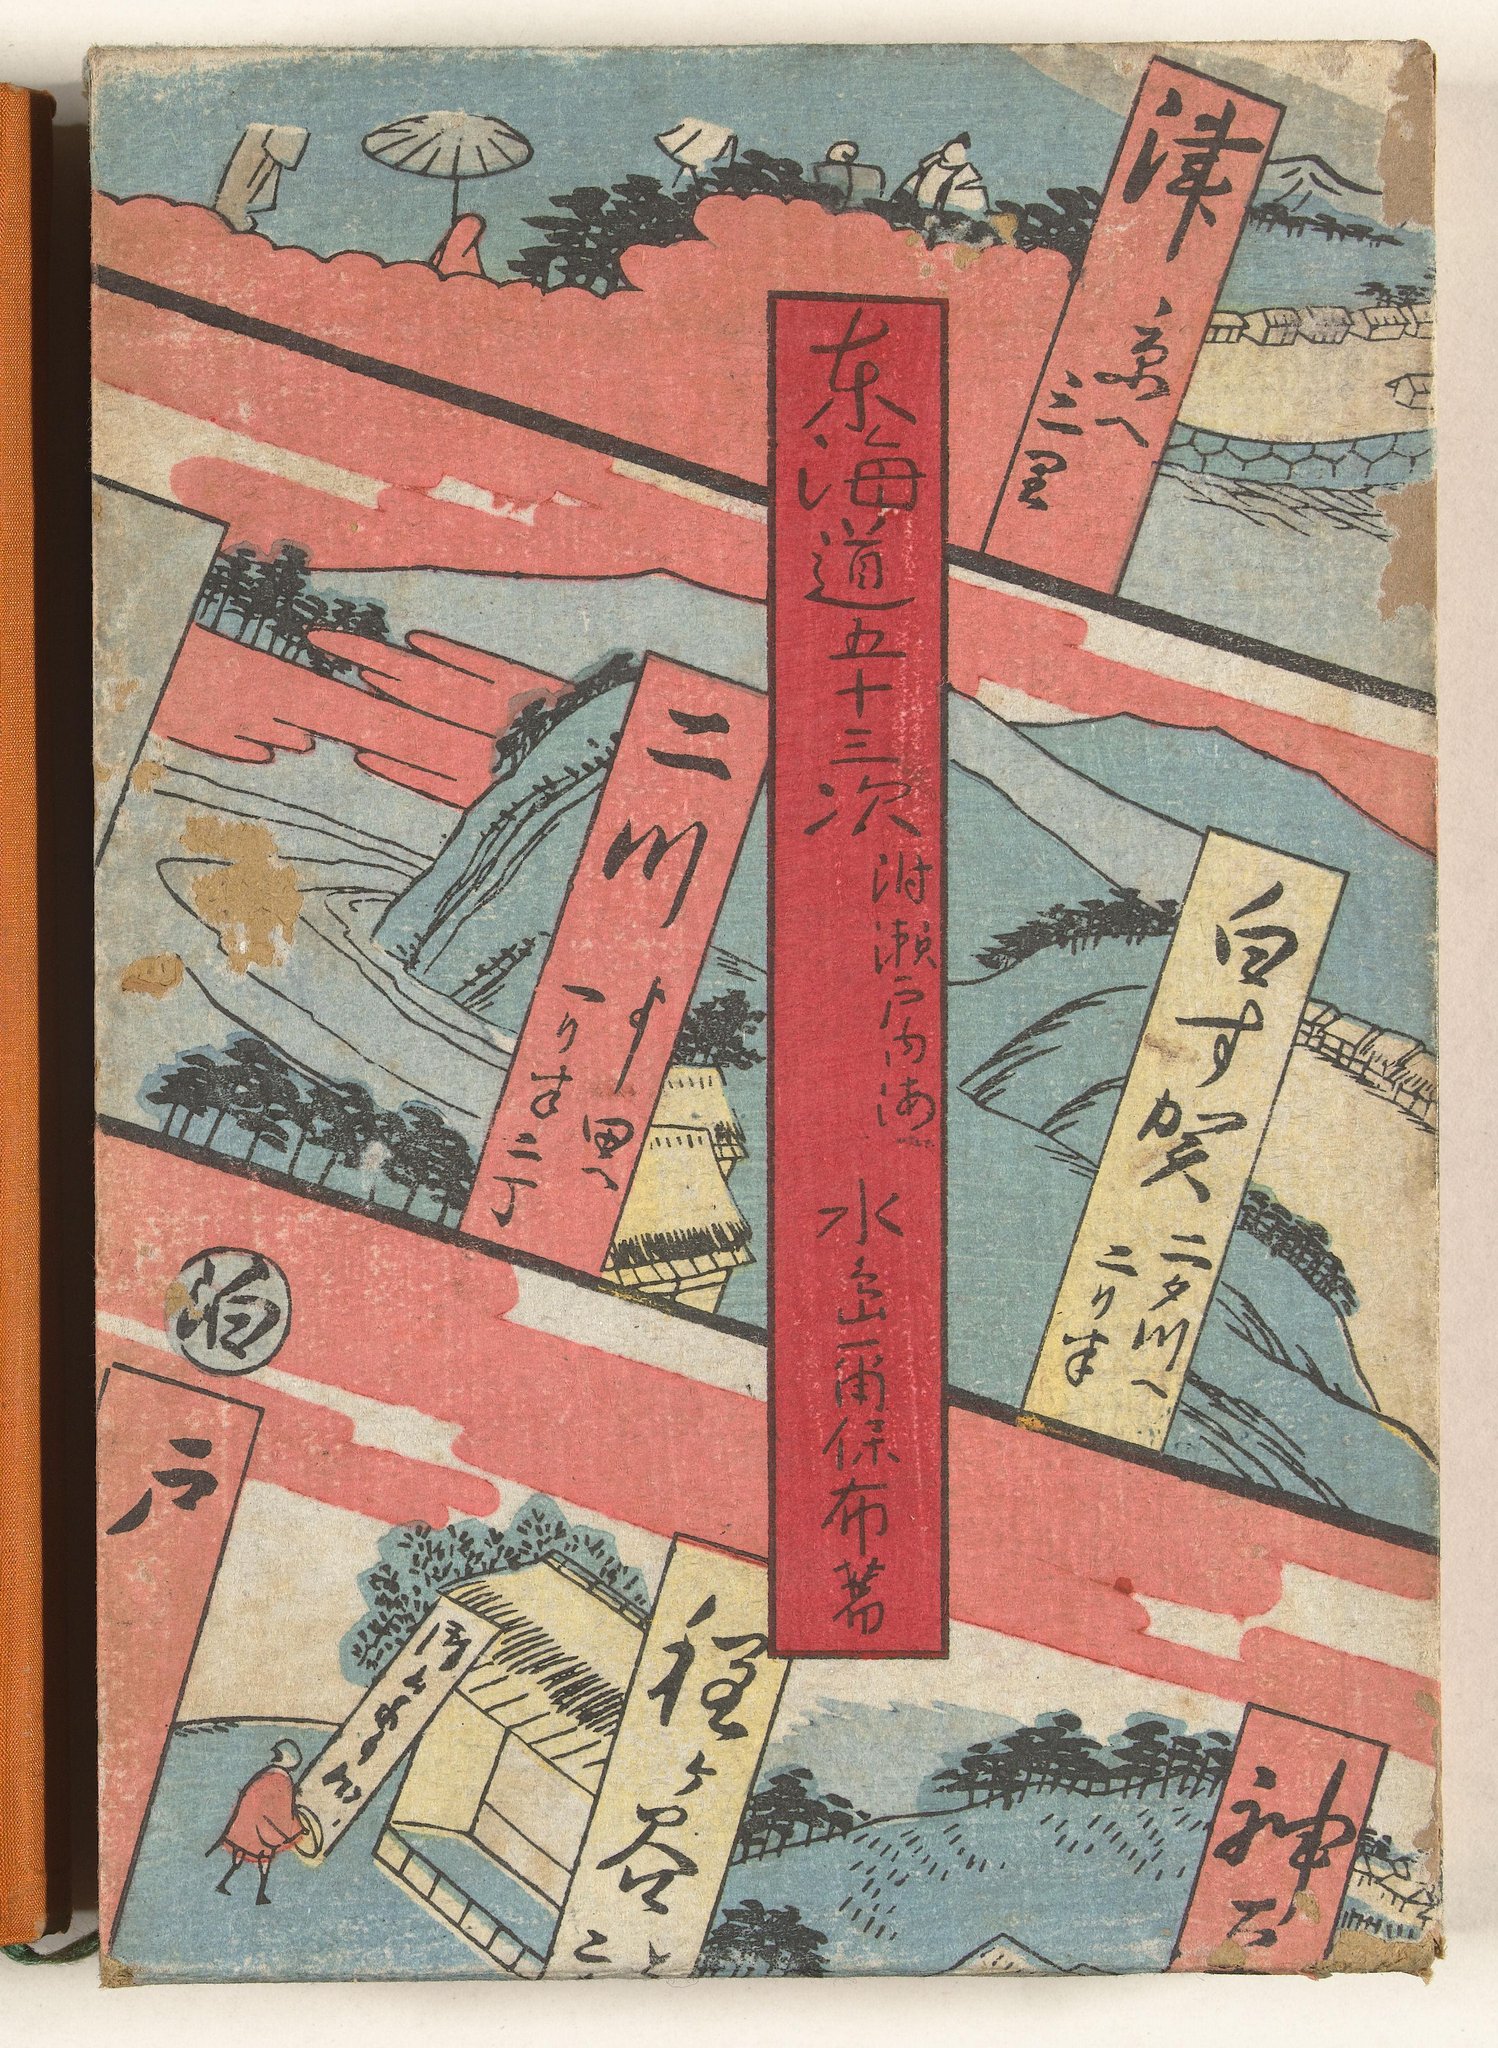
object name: book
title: De 53 stations van de Tokaido en de Japanse Binnenzee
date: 1903-1920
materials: paper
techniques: woodcut, letterpress printing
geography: tokyo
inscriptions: date